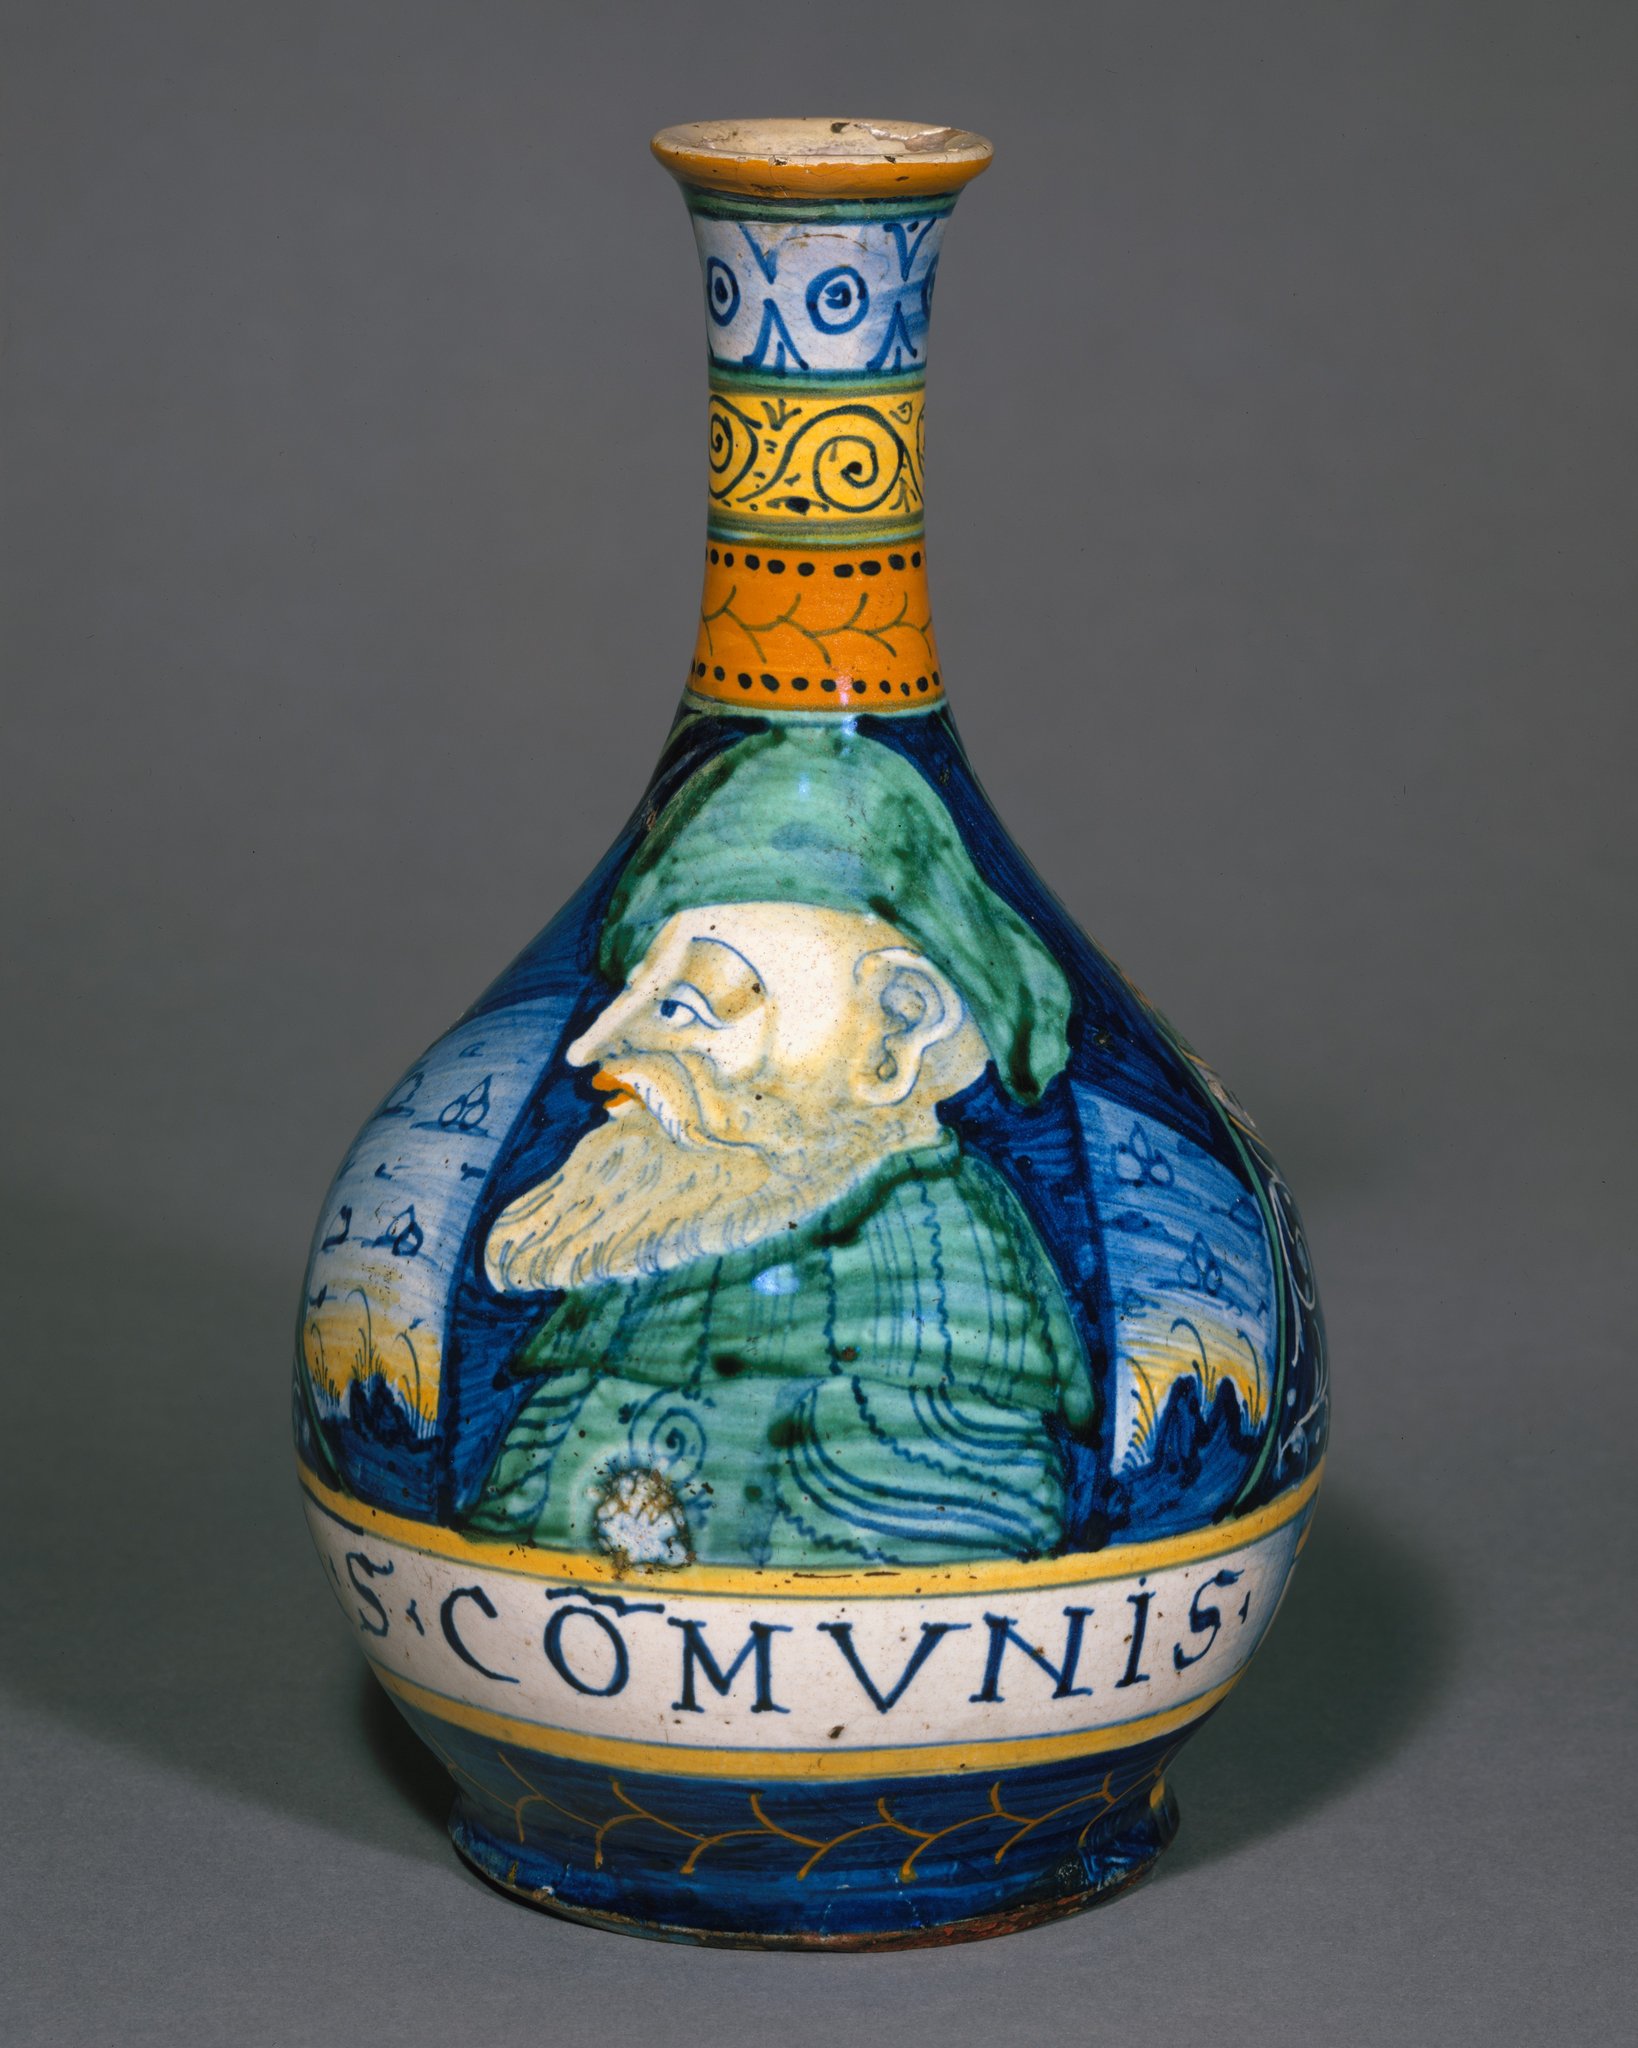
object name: apothecary bottle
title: Apothecary bottle (fiasca da farmacia)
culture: italian, castelli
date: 1530-1540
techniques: maiolica, glazing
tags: men,profiles